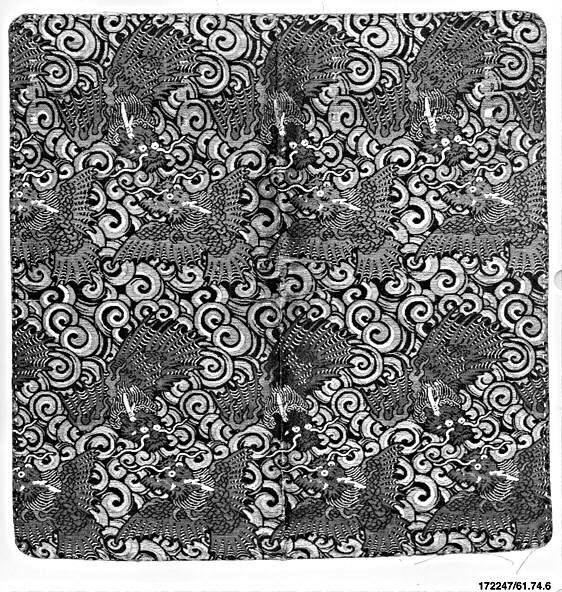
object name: piece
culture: japanese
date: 1867-1900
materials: silk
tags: mythical creatures